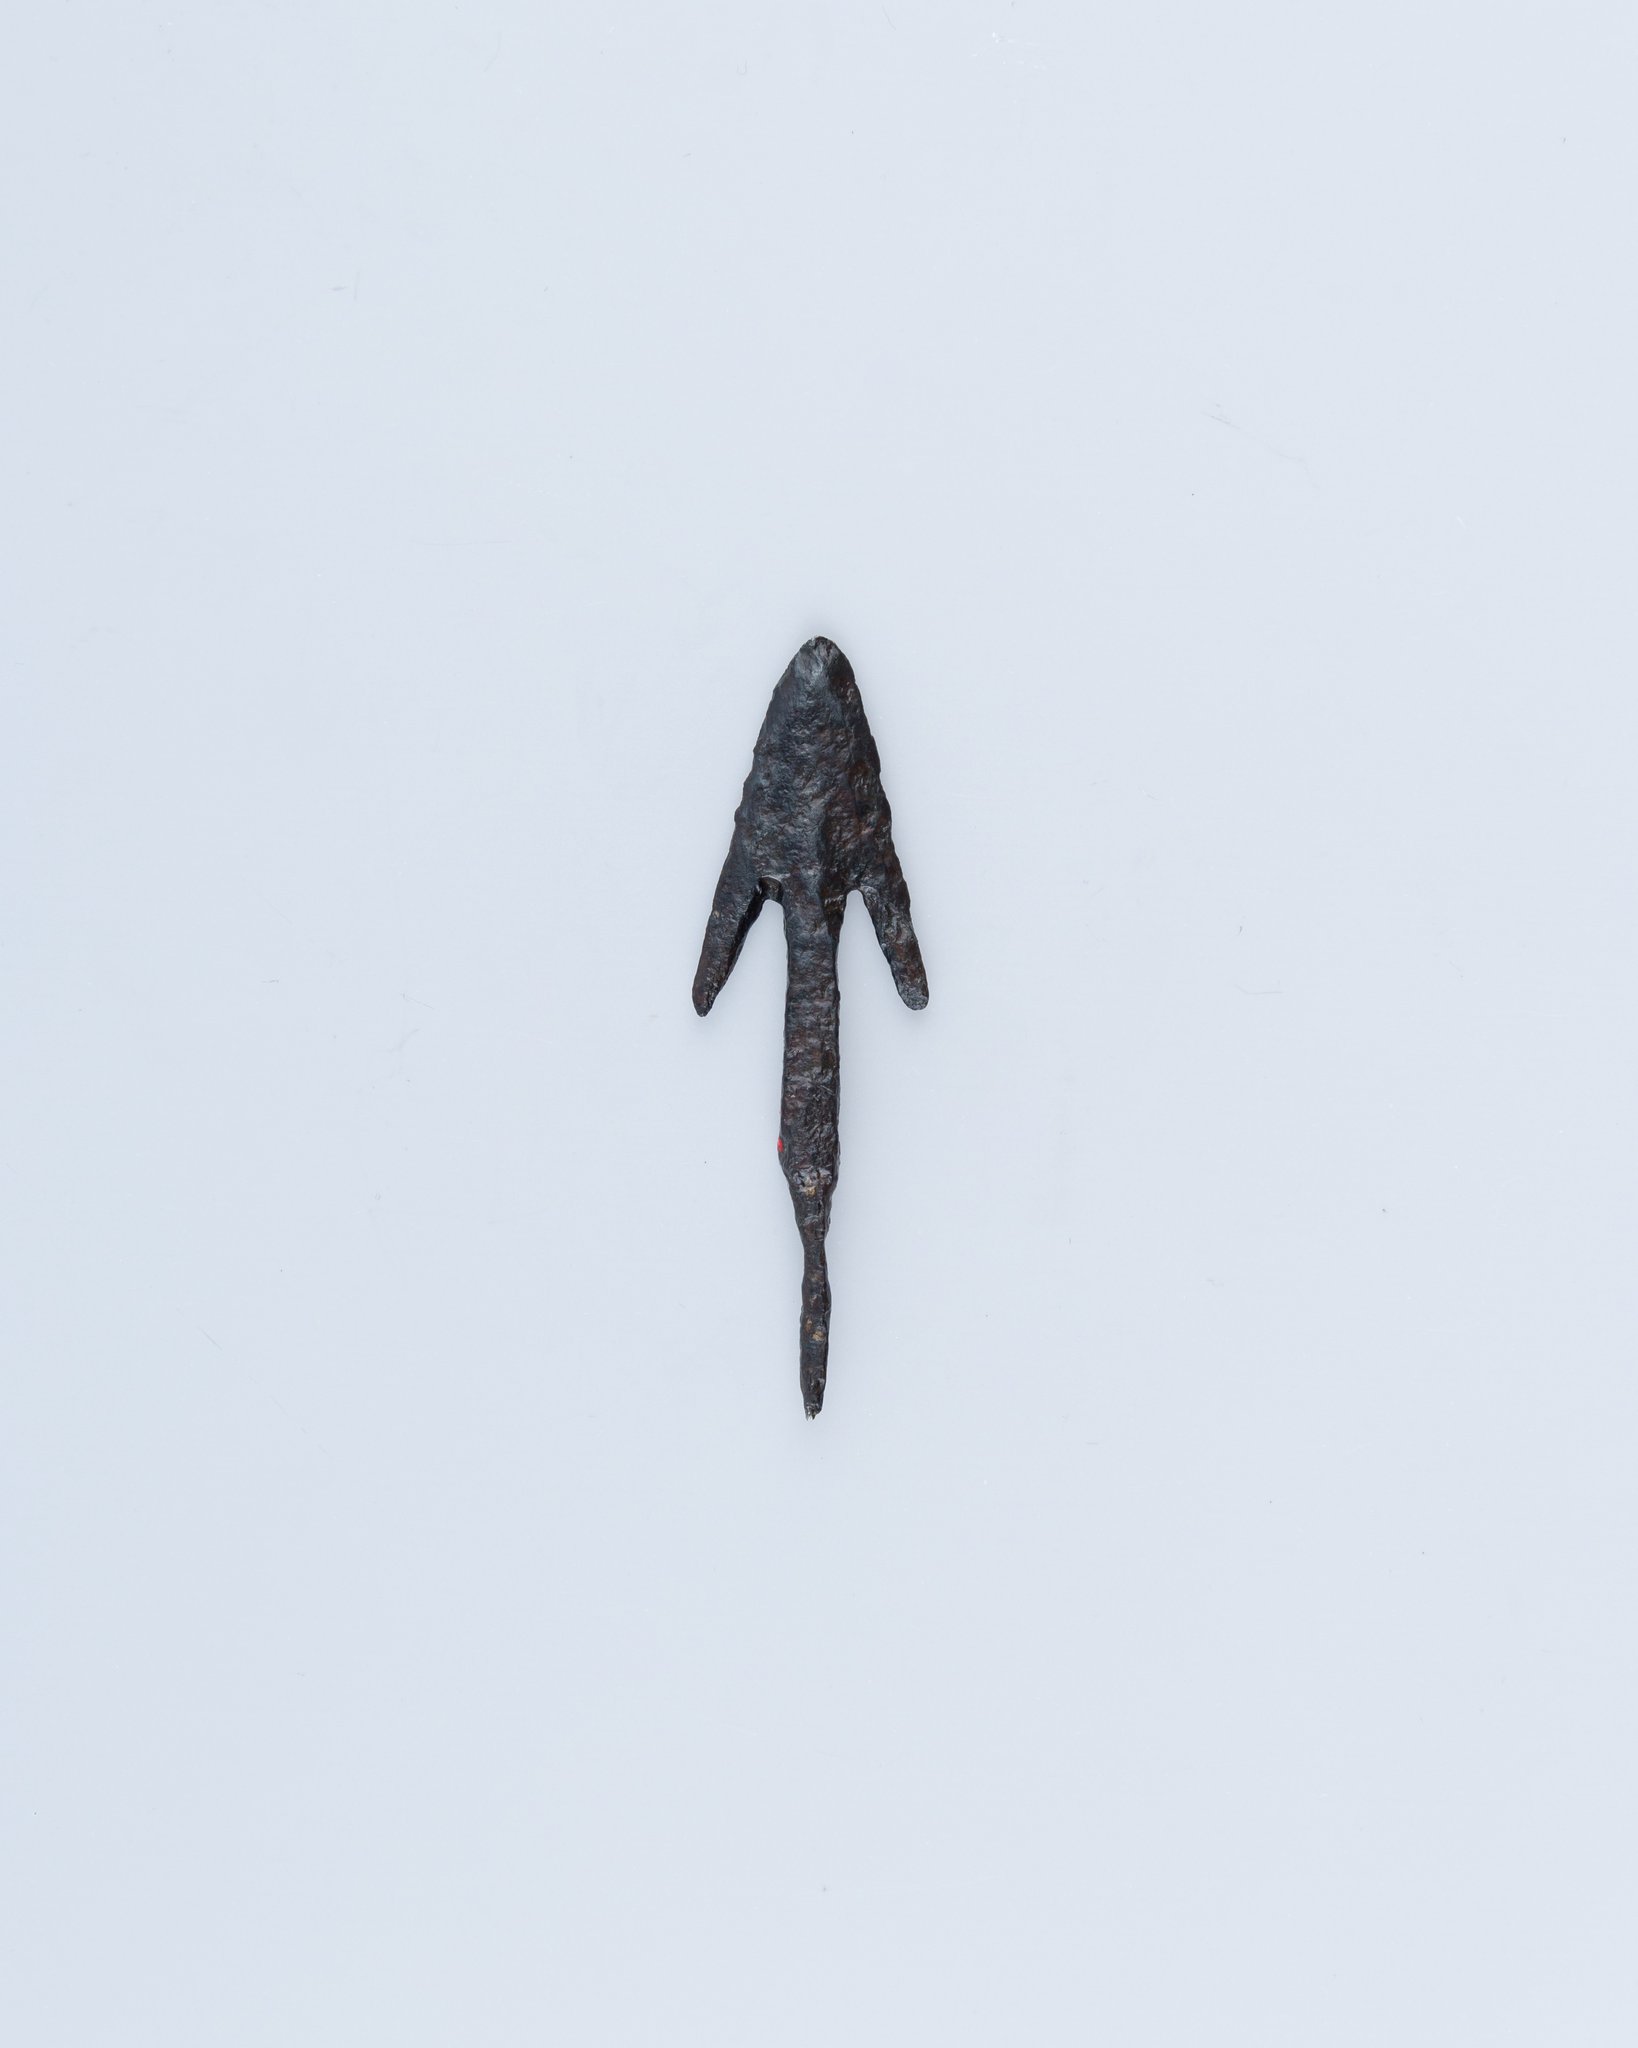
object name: arrowhead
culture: tibetan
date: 1401-1700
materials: iron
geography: tibet